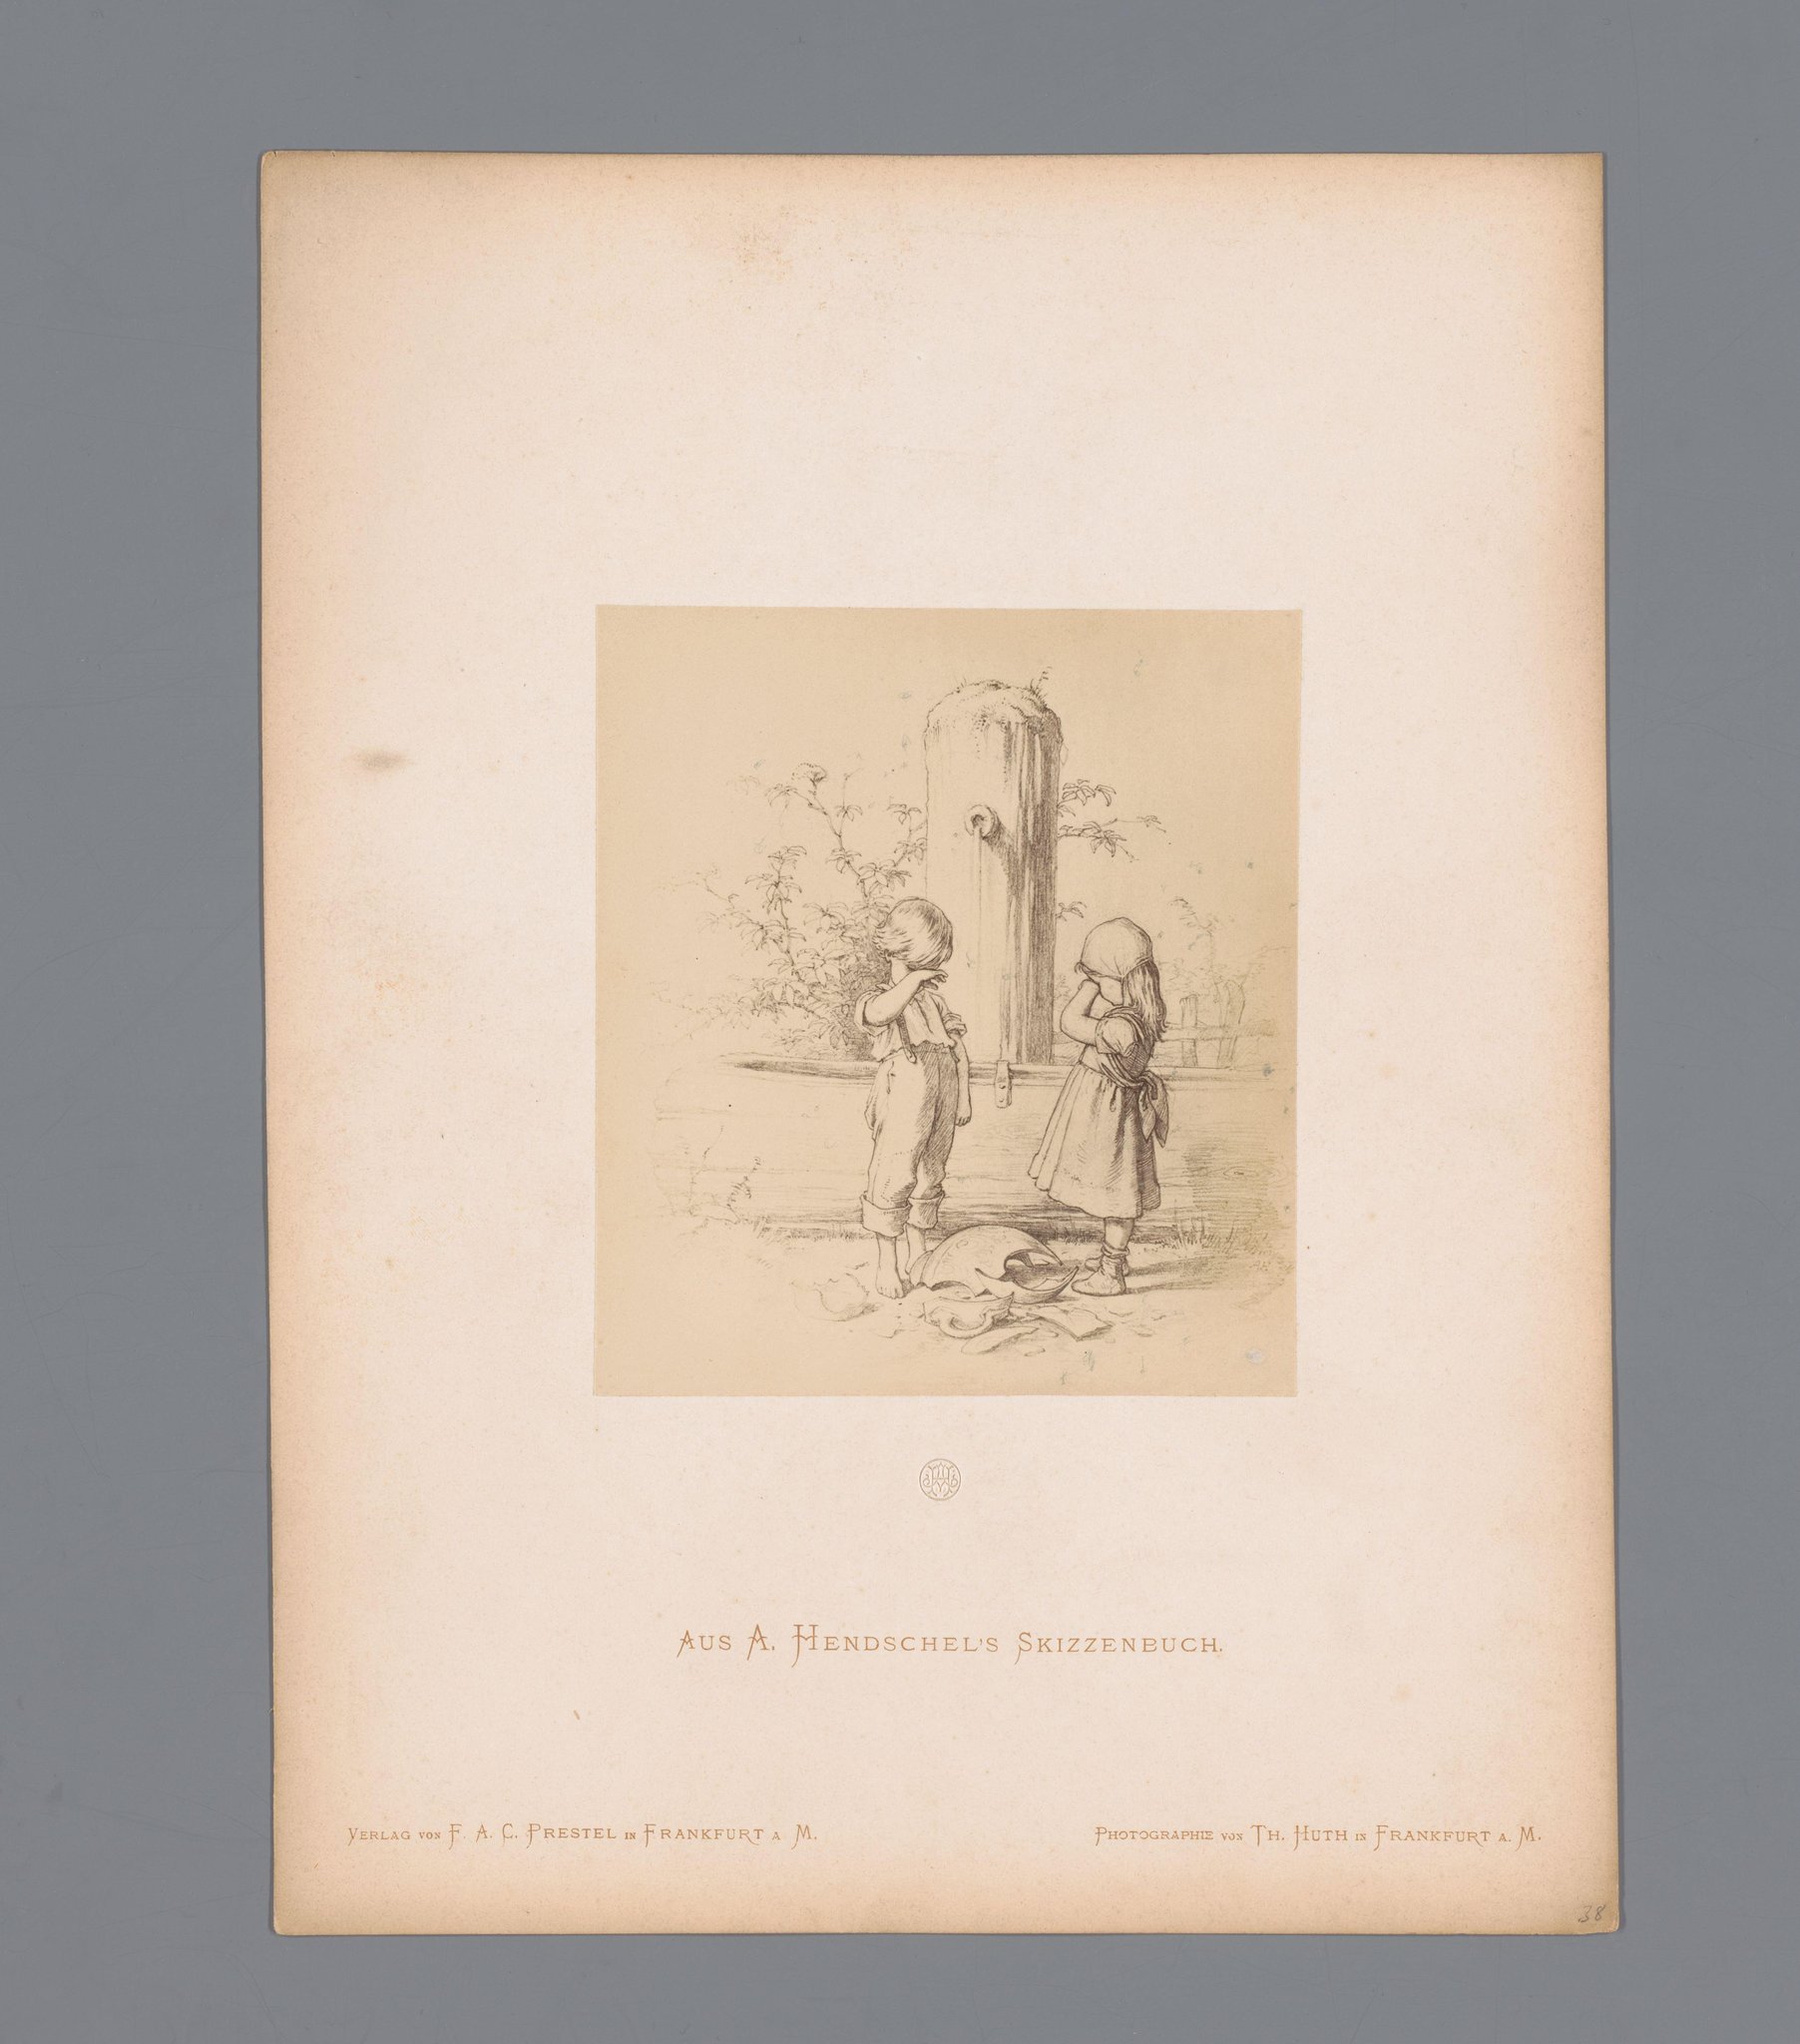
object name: photograph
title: Aus A. Hendschel's Skizzenbuch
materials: photographic support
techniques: albumen print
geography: frankfurt am main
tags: well, child (+ two persons)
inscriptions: monogram: ‘AH’, number: ‘38’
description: Deze foto maakt deel uit van een omslag met 50 foto's op 48 bladen, een lijst van afbeeldingen en een titelblad.